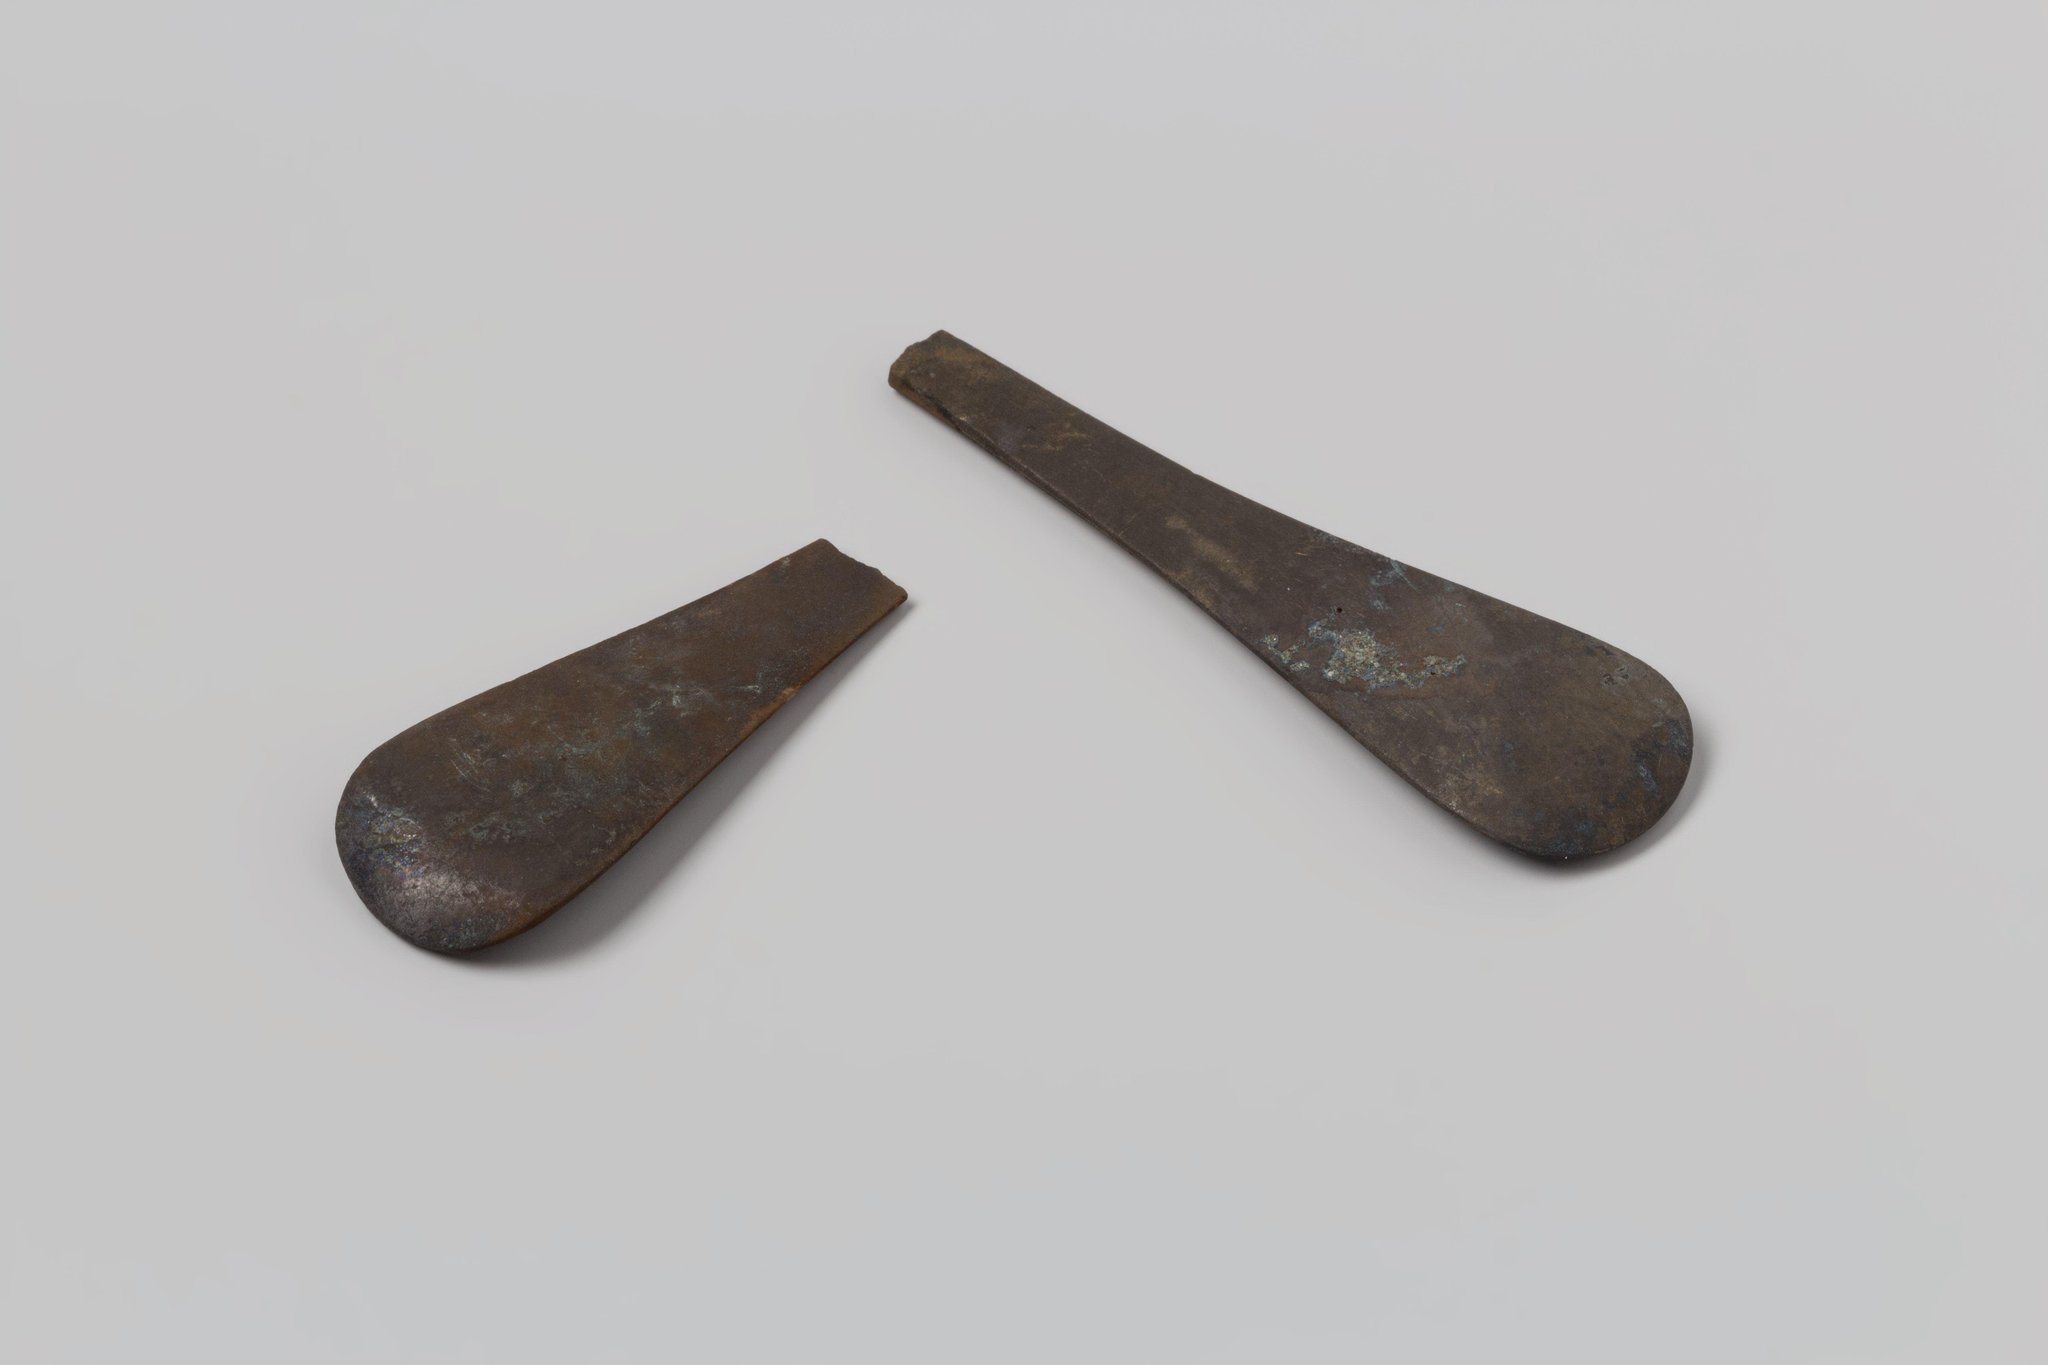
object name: spoon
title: Stelen van vorken of lepels uit het wrak van de Oost-Indiëvaarder Hollandia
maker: Anonymous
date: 1700-1743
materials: copper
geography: netherlands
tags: verenigde oostindische compagnie, hollandia (schip), annet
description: Cutlery, fragment: stem of fork or spoon; fragm ends, flat, widening, curved, fragm shows remains of coatings.